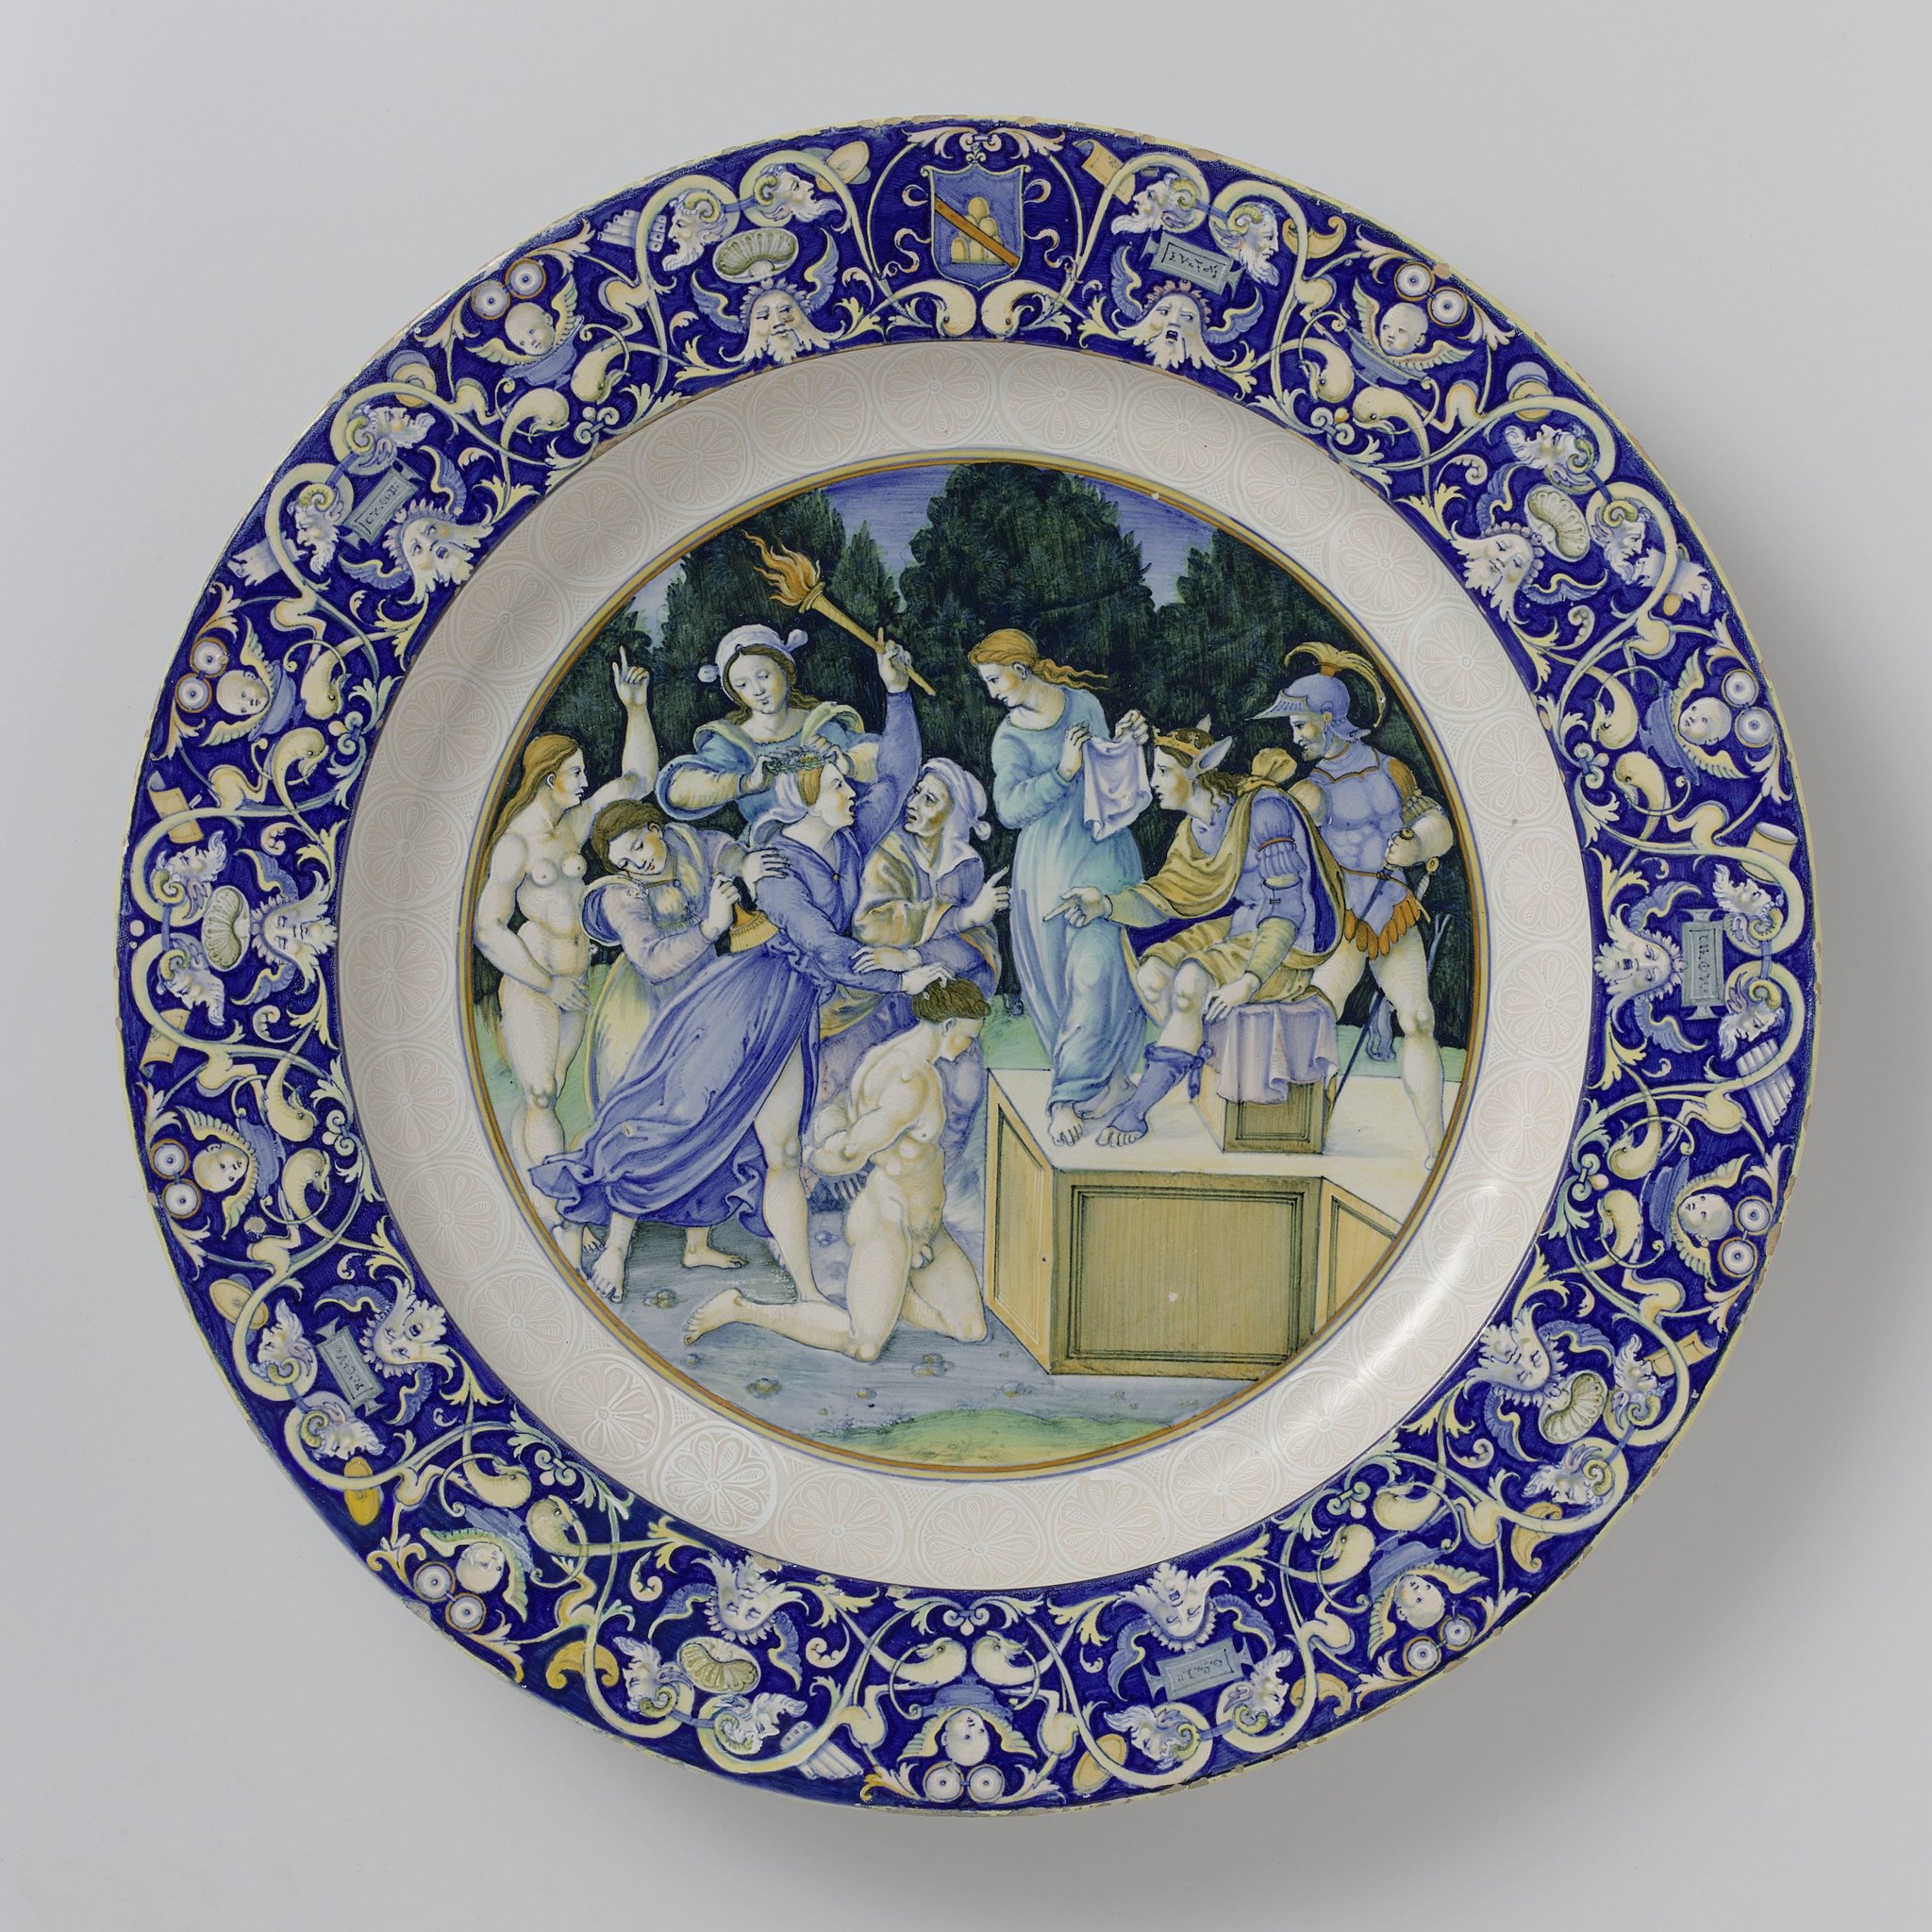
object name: platter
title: Dish with the Calumny of Apelles and the arms of the Ridolfi family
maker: nicolá da urbino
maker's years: -1538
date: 1520-1525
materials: earthenware, glaze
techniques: maiolica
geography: urbino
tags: calumny of apelles: bad judge with ass's ears on throne, with deceit, envy, ignorance, suspicion and treachery, confronted with innocent accused; remorse and truth present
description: This scene is based on a description of a famous, lost painting by the ancient Greek Apelles. A naked youth – Innocence – is dragged before a stupid judge (with ass’s ears!), whose view is blocked by Ignorance holding a white cloth. Slander (Calumny), with a torch, accuses the innocent youth. Naked Truth stands behind him, but nobody listens to her